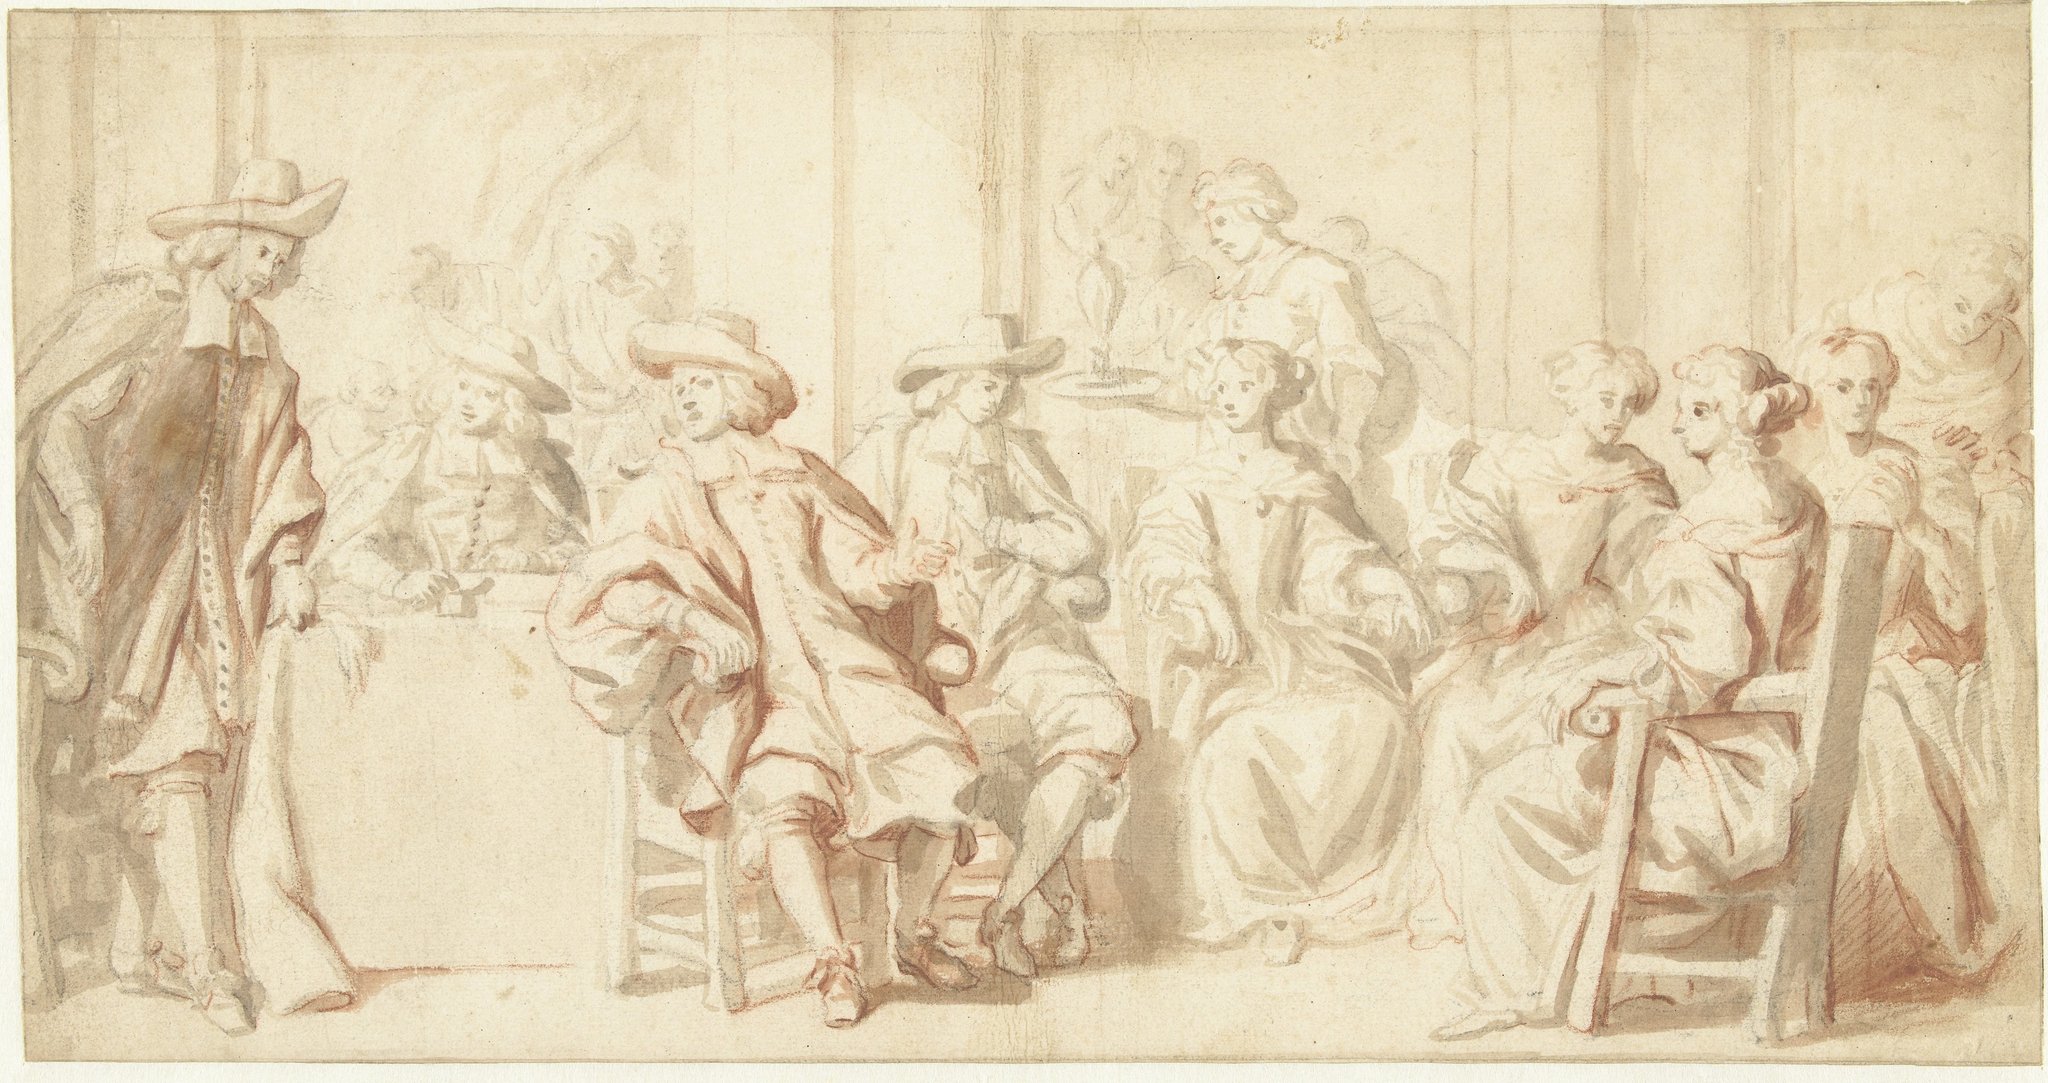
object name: drawing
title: Portretstuk met vier regenten en vier regentessen, een bediende en een meid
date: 1618-1651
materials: chalk, paper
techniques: brush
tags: sitting figure, sitting figure - aa - female human figure, visiting; receiving guests; elegant company, banquet of elegant company, house personnel, servants